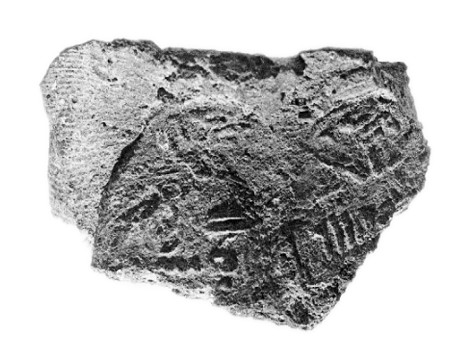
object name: sealing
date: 1981-1640 BCE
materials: mud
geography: egypt